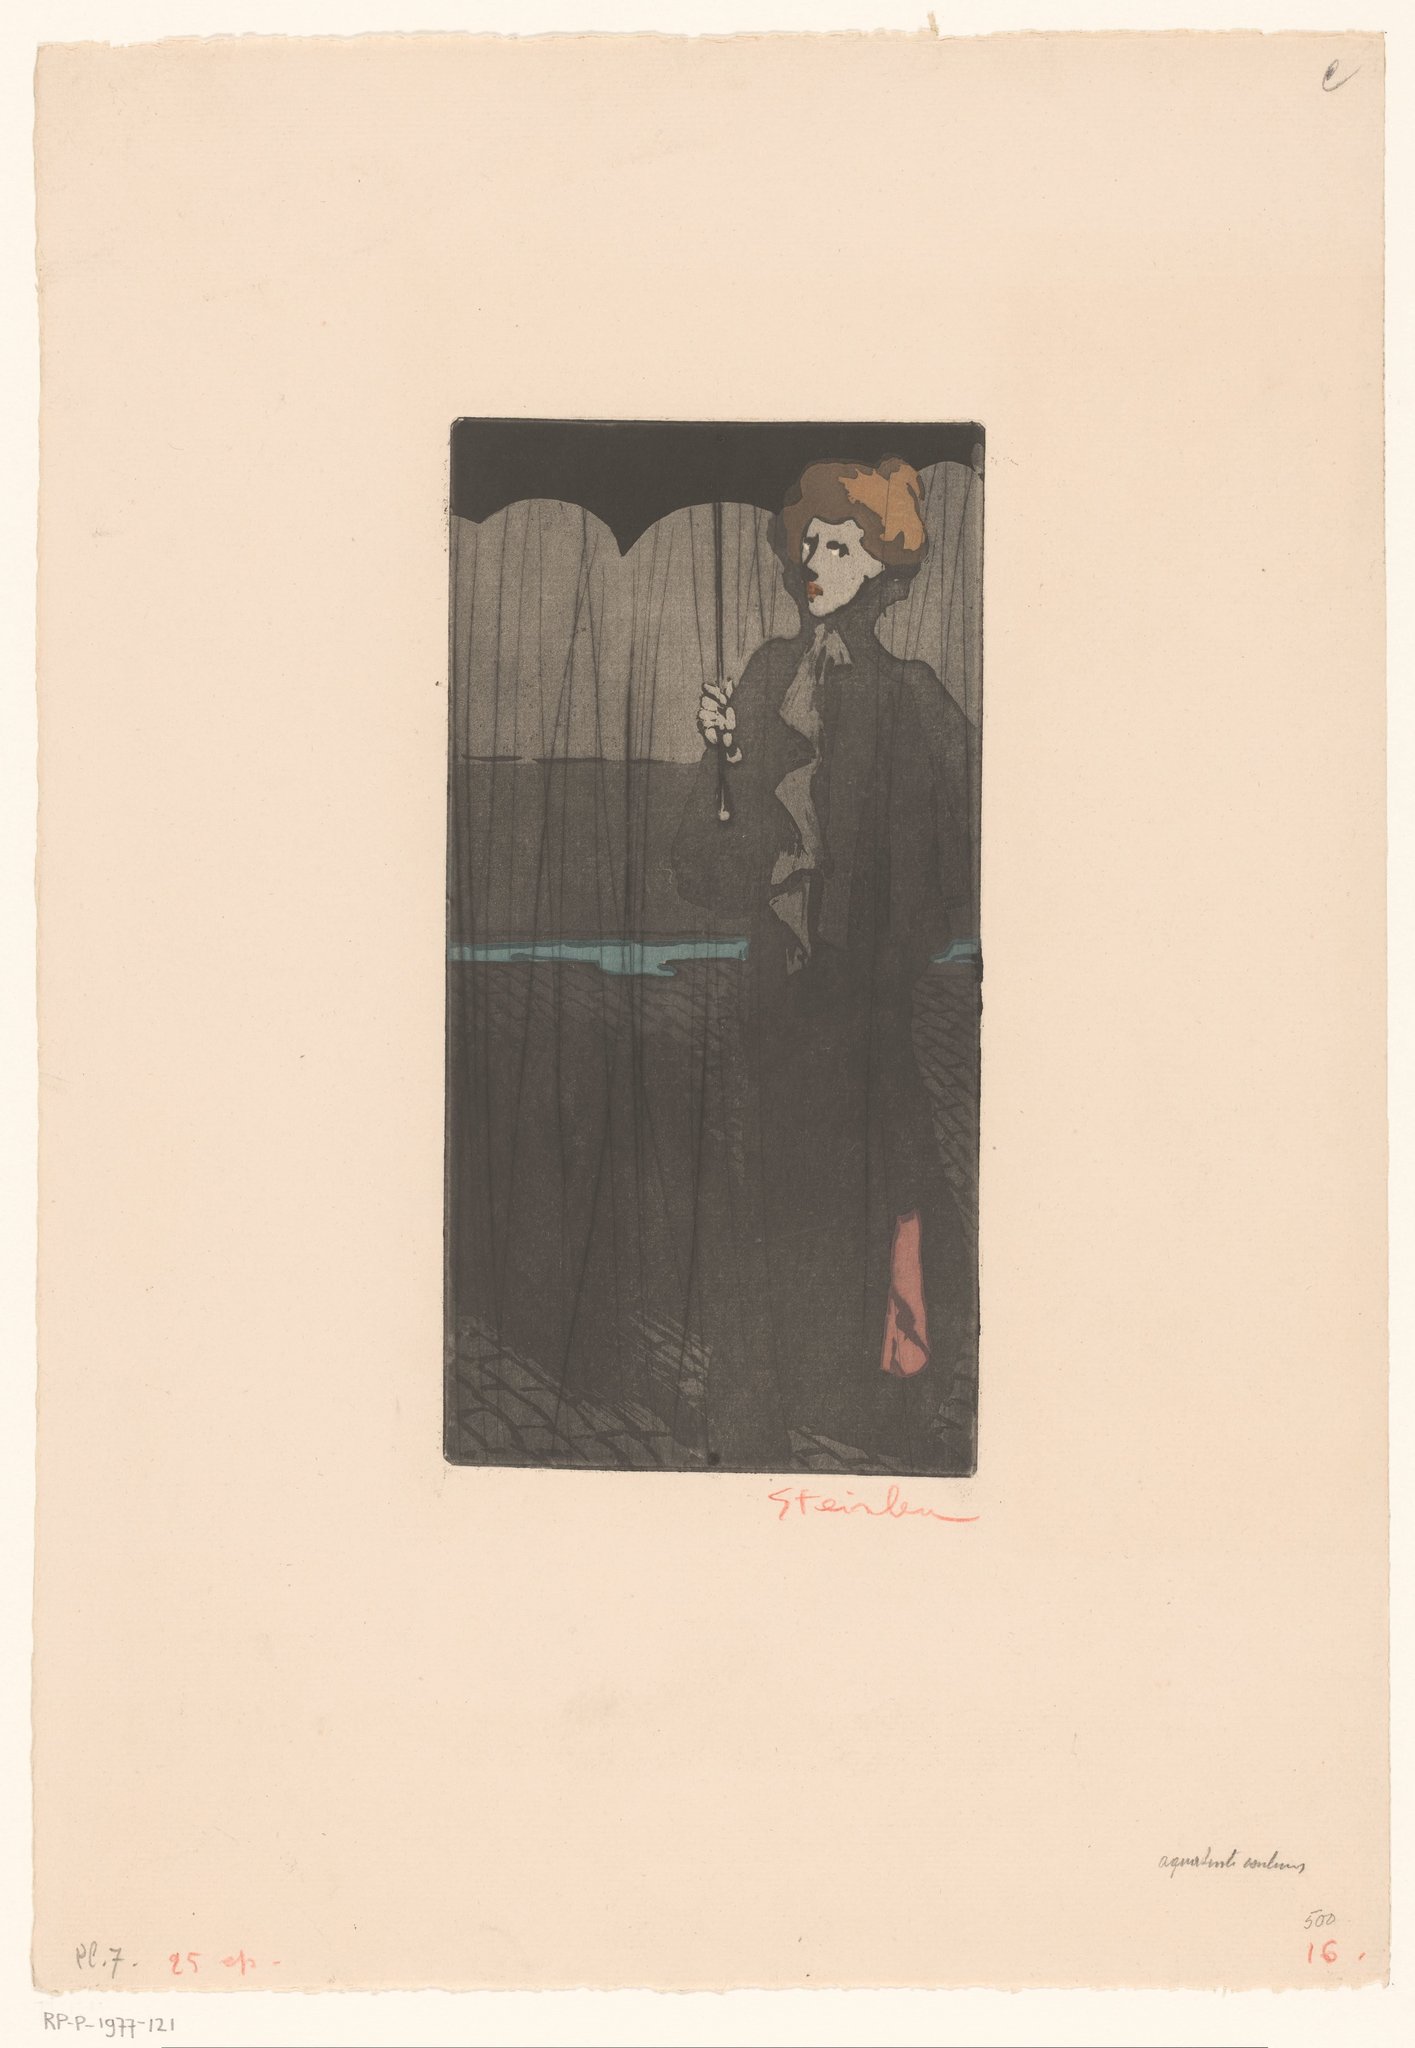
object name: print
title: Vrouw met paraplu in de regen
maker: théophile alexandre steinlen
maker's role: draughtsman, painter, print maker, sculptor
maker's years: 1859-1923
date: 1898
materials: paper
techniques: aquatint, drypoint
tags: adult woman, rain, umbrella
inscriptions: collector's mark: Lugt 2228, collector's mark: Lugt 2760